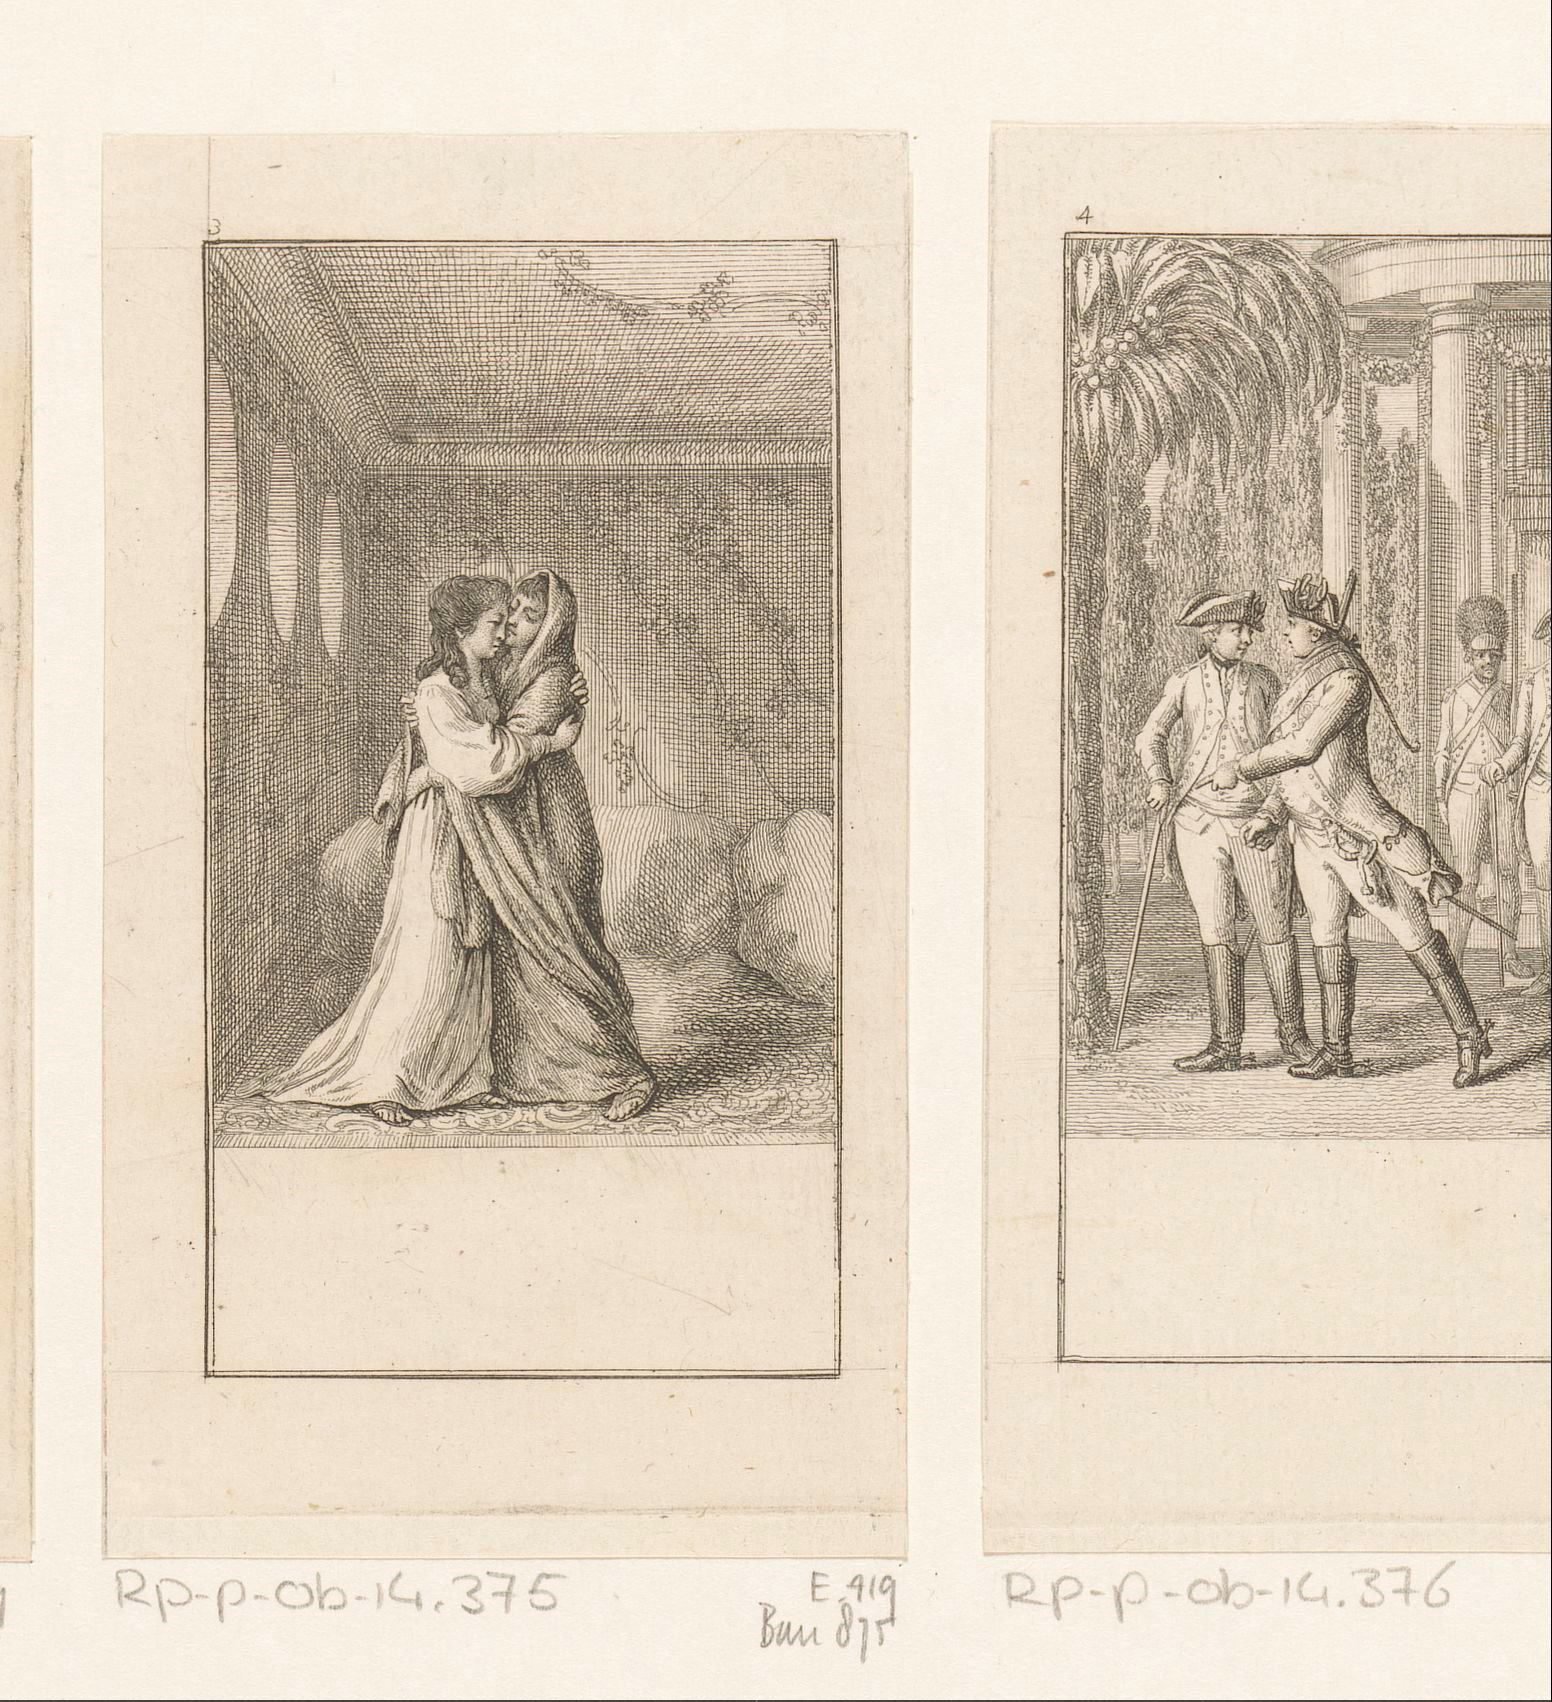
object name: print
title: Lanassa herkent in de jonge brahmaan haar broer en omhelst hem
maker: daniel nikolaus chodowiecki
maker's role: draughtsman, print maker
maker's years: 1726-1801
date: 1782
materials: paper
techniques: etching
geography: berlin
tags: literature, embracing each other, kissing, brothers or sisters (second degree family relationships)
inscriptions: collector's mark: Lugt 2228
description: Vervaardigd voor Karl Martin Plümicke's 'Lanassa'. Latere staat gebruikt voor: Köningl. Grosbr. Genealogischer Kalender auf das 1783 Jahr. Lauenburg: J. G. Berenberg, 1782.